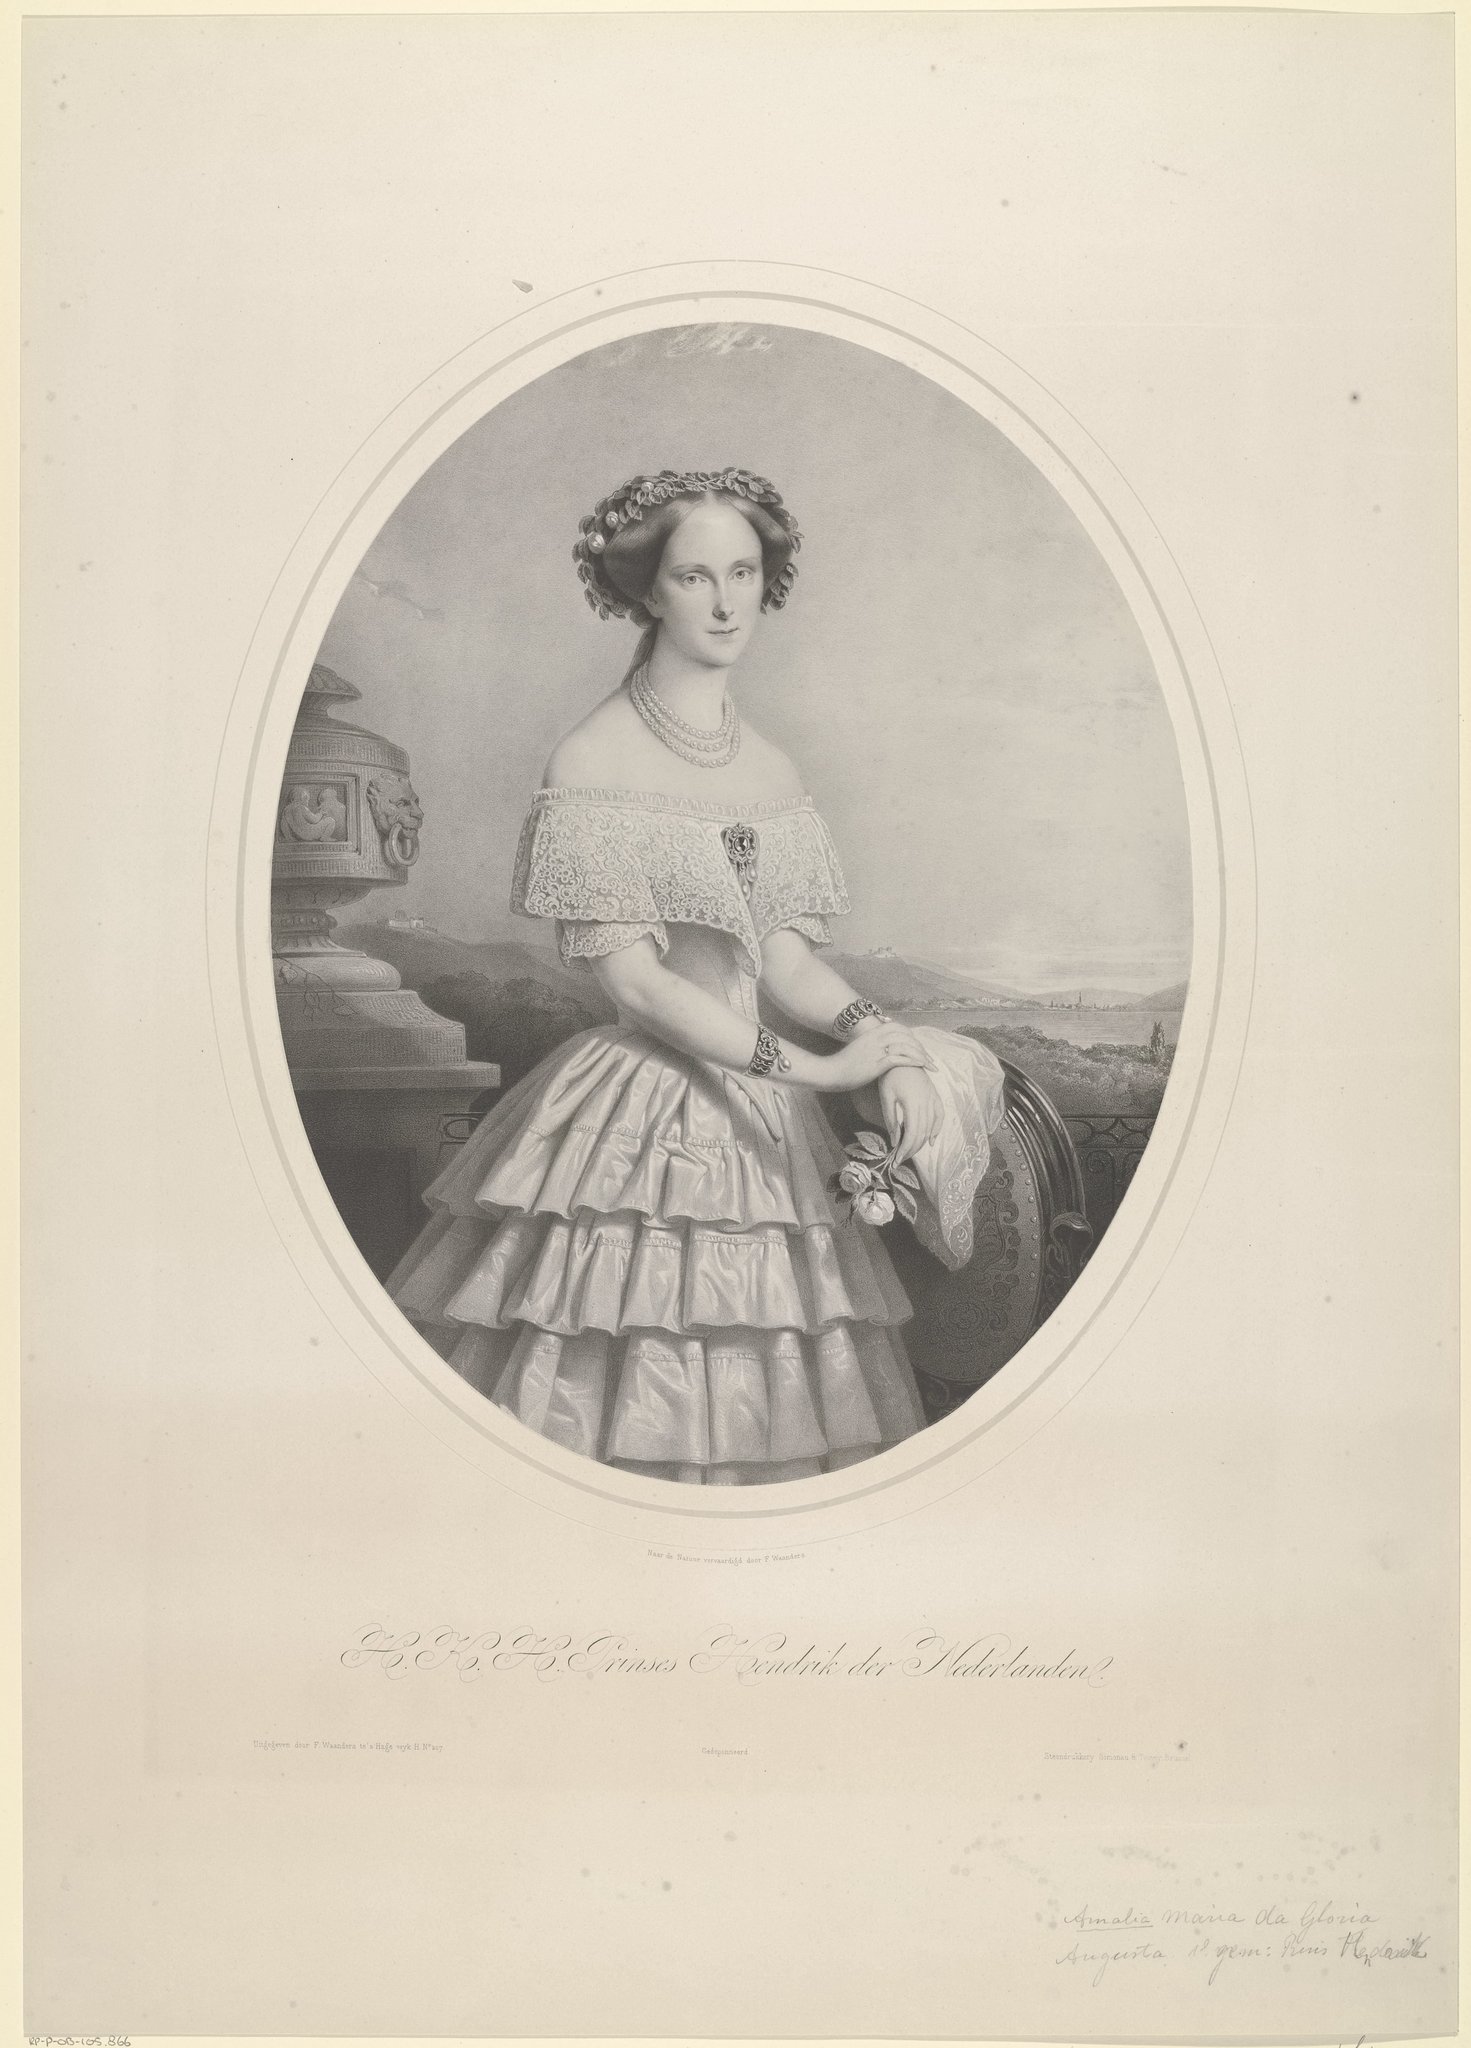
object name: print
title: Portret van Amalia van Saksen-Weimar-Eisenach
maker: franciscus bernardus waanders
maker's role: print maker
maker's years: 1809-1880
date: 1853-1871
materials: paper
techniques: lithograph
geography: netherlands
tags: historical persons - bb - woman, princess, balcony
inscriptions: collector's mark: Lugt 963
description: Portret van Amalia van Saksen-Weimar-Eisenach in een ovaal. Ze staat op een balkon. Op de achtergrond een rivier. In de ondermarge haar titel.